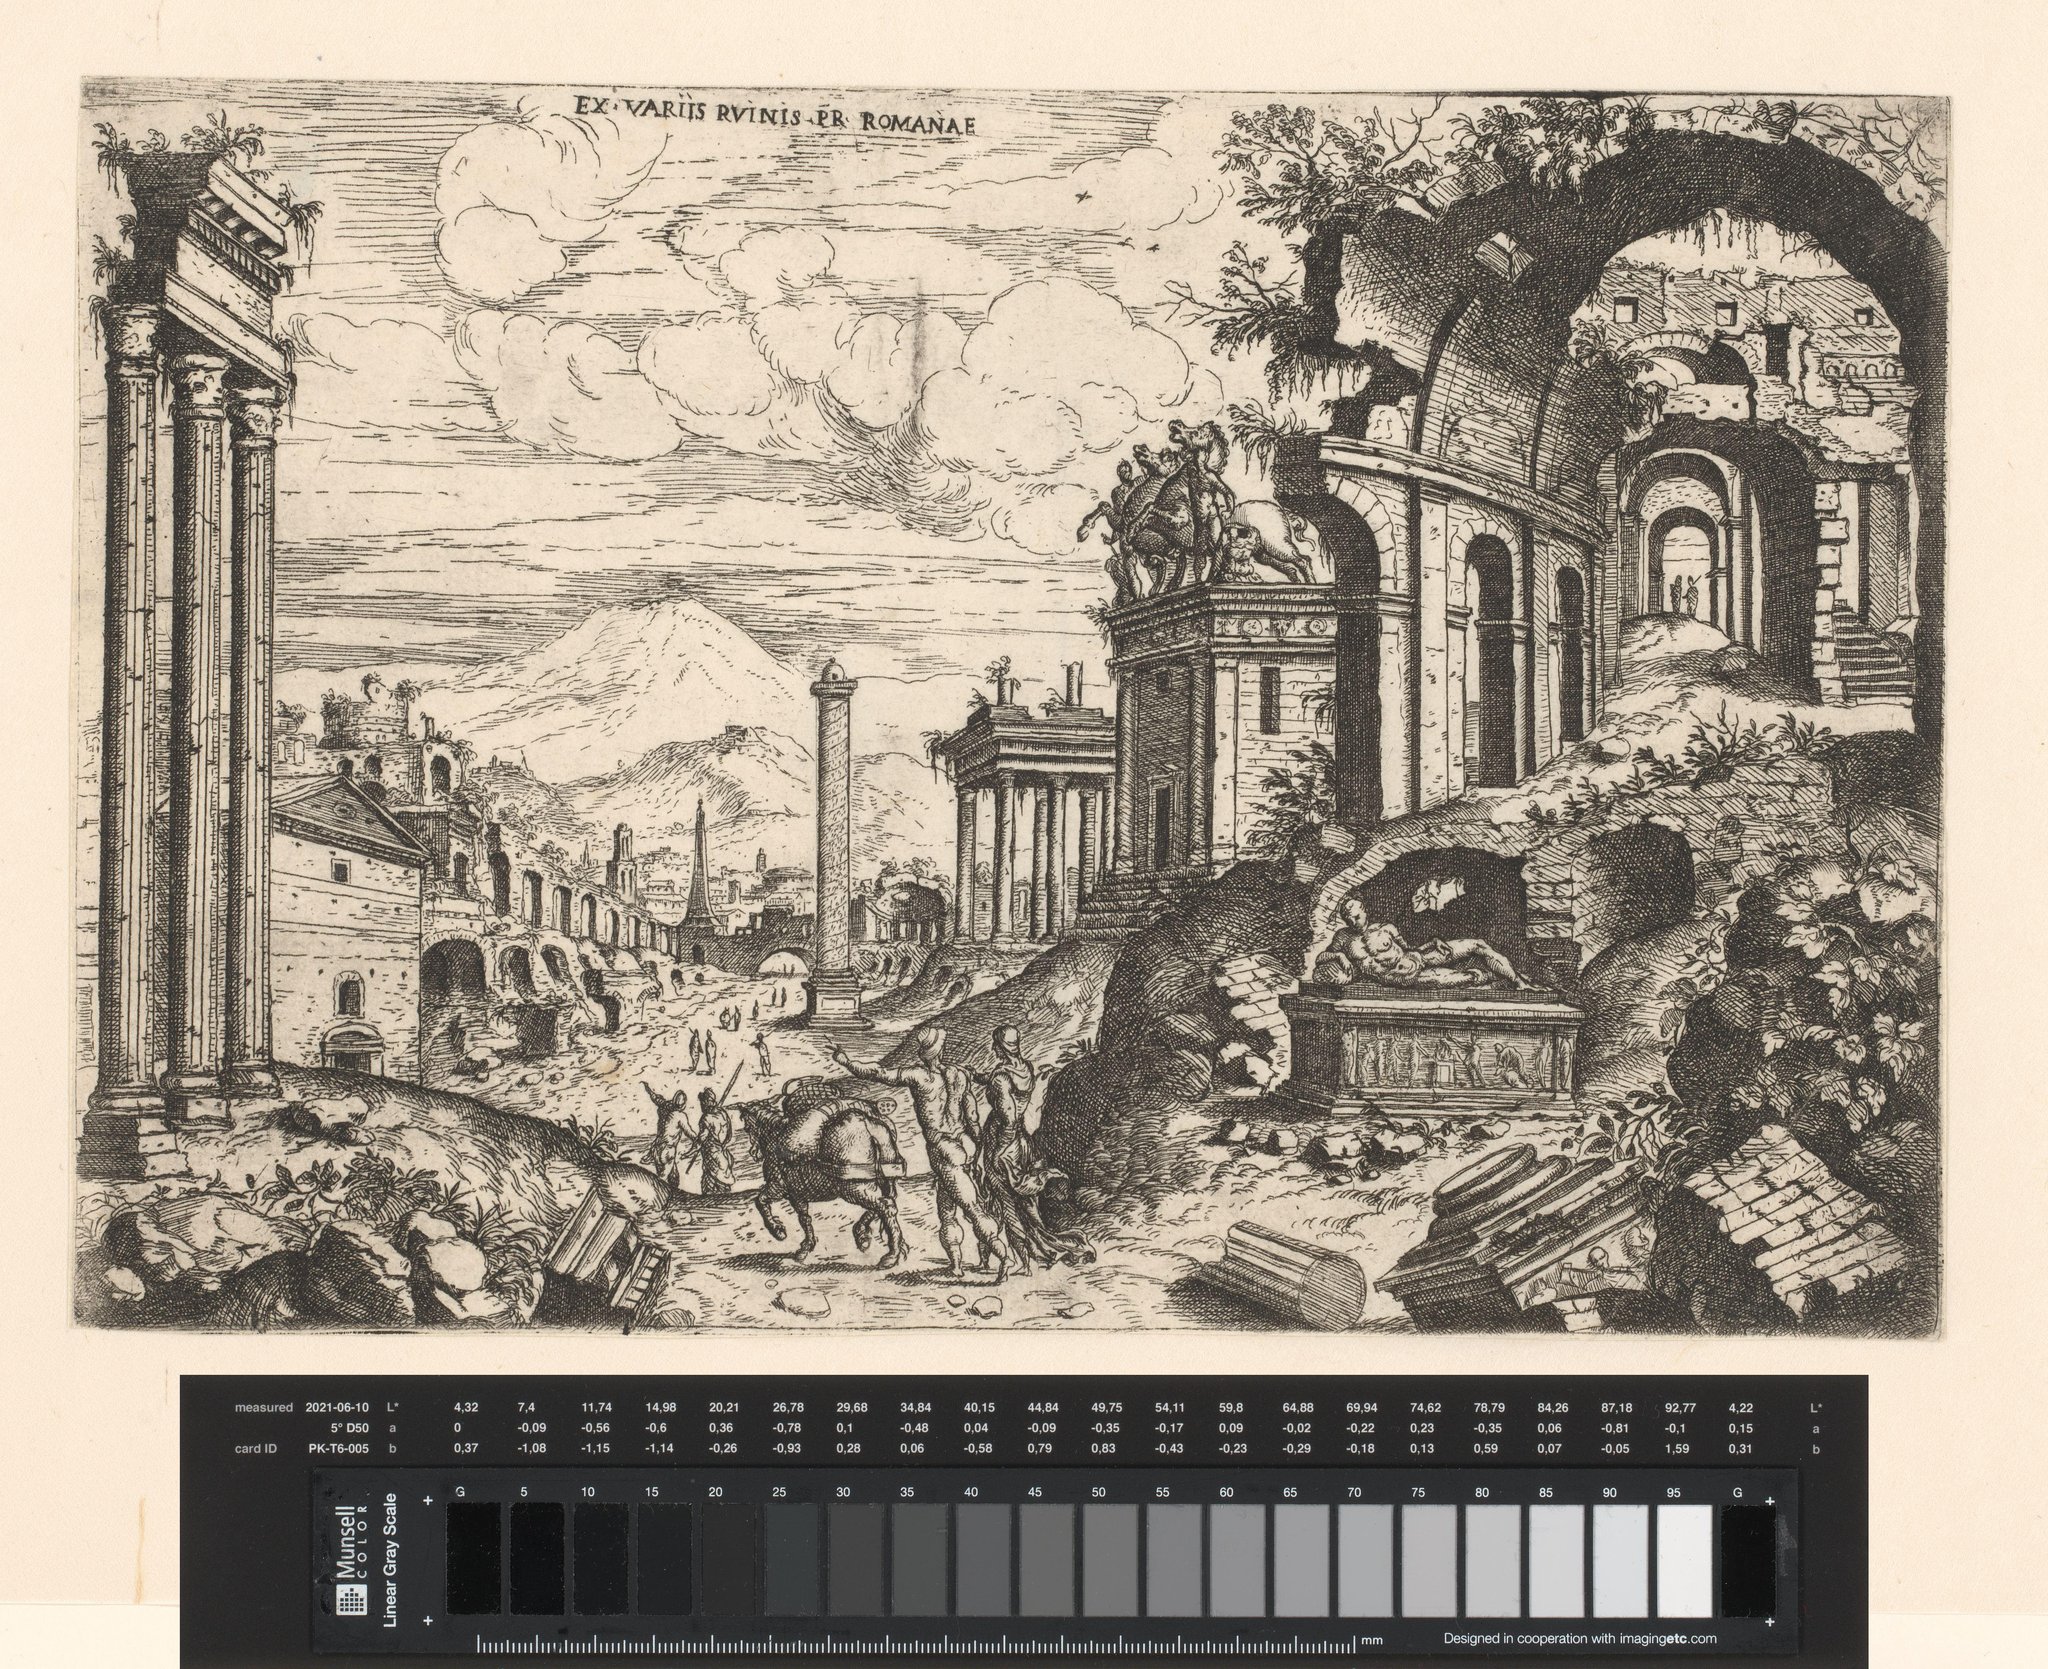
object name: print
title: Landschap met ruïnes en reizigers (EX. VARIIS RVINES PR. ROMANAE)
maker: giovanni battista pittoni (i)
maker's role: print maker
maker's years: 1520-1583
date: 1561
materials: paper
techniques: etching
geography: vicenza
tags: landscape with ruins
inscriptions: collector's mark: Lugt 2228, collector's mark: Lugt 2760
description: Fantasielandschap met antieke ruïnes en reizigers op een weg. Rechts zijn de beelden van de twee Dioskuren ter herkennen en in de achtergrond de zuil van Trajanus. Uit een serie met negentien fantasielandschappen met ruïnes uitgegeven in 1561.